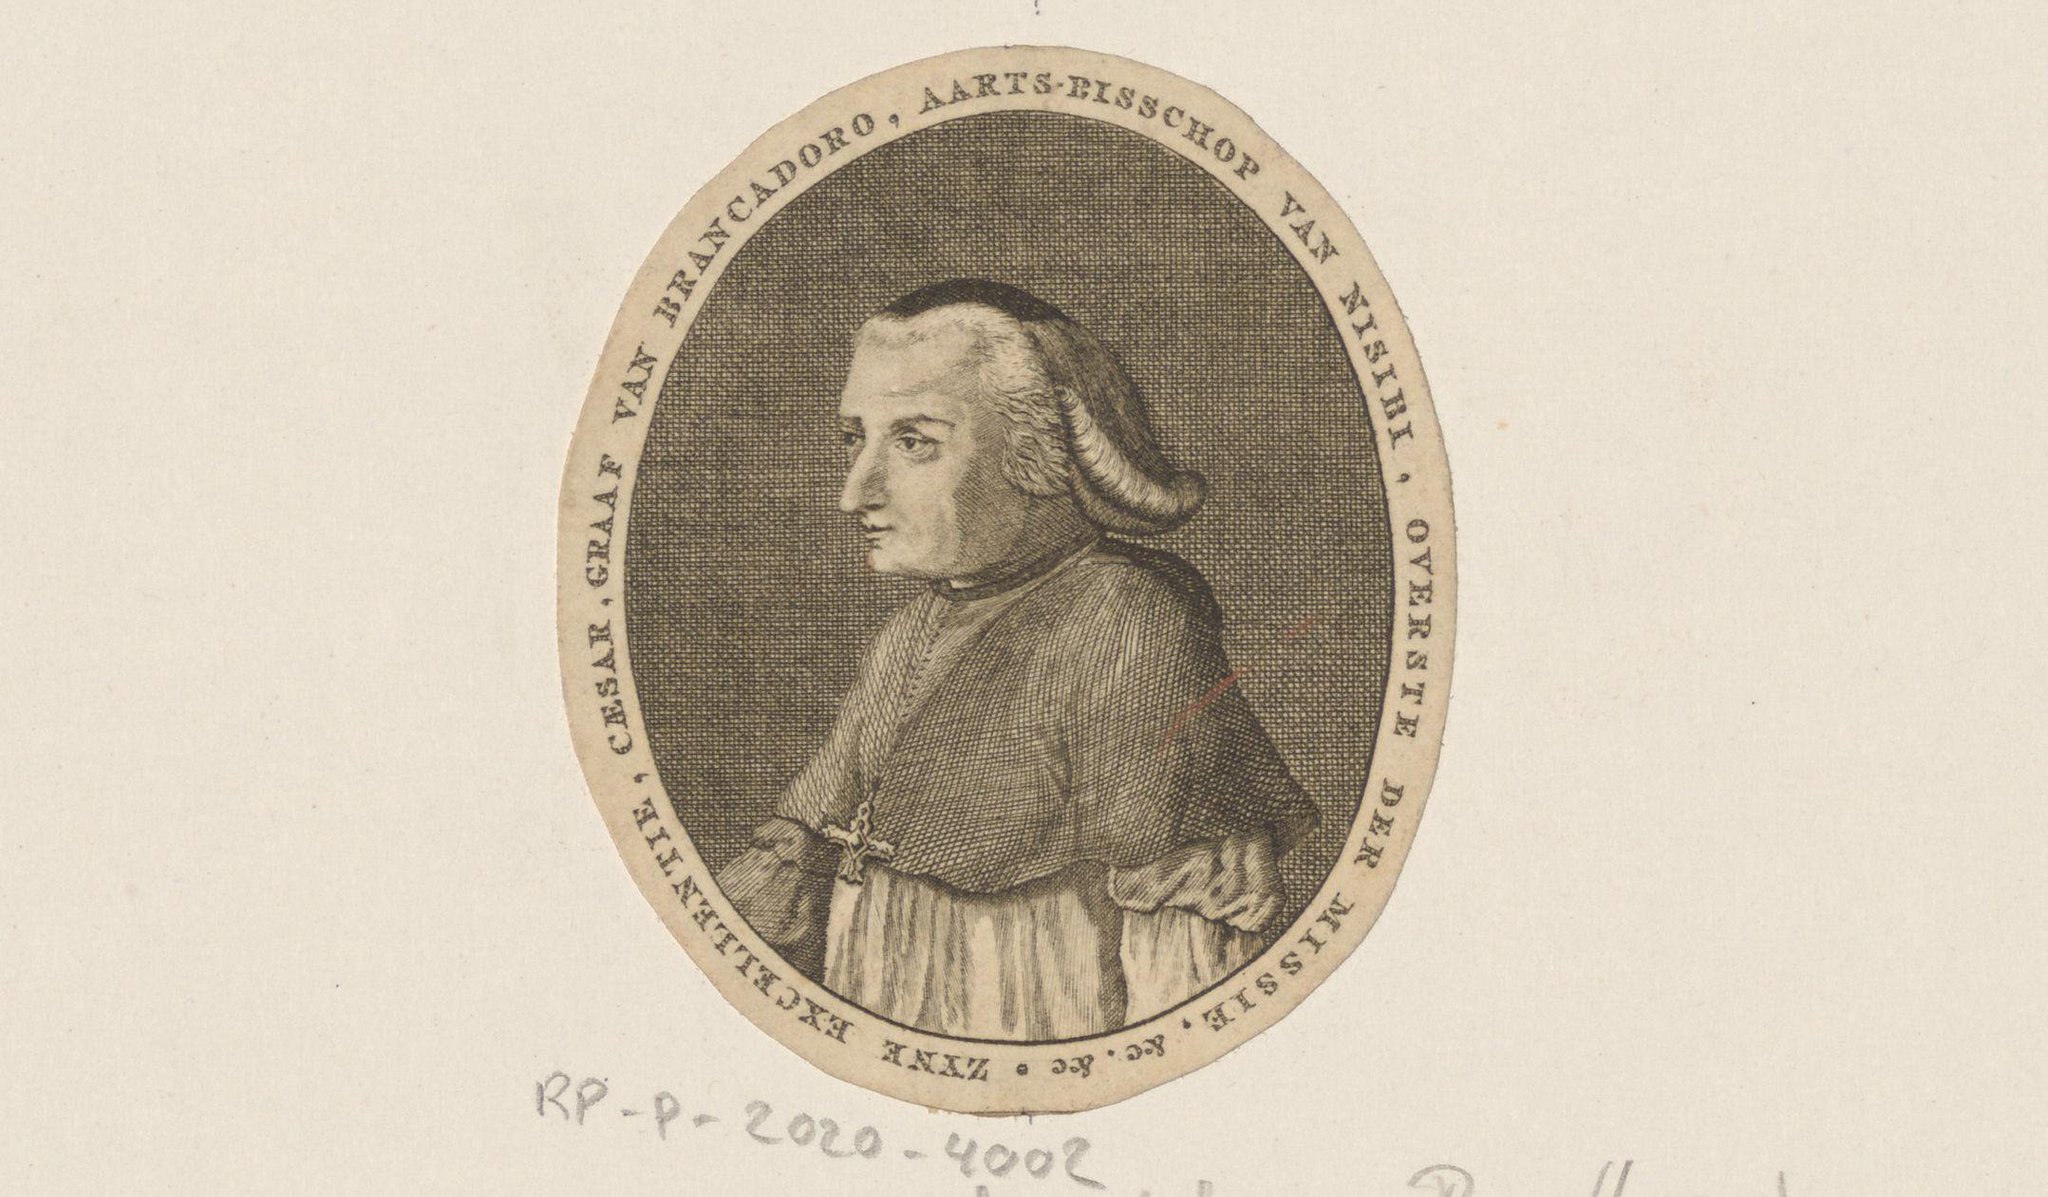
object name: print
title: Portret van Cesare Brancadoro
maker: Anonymous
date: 1789-1849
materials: paper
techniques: etching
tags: rome, cardinal, historical persons